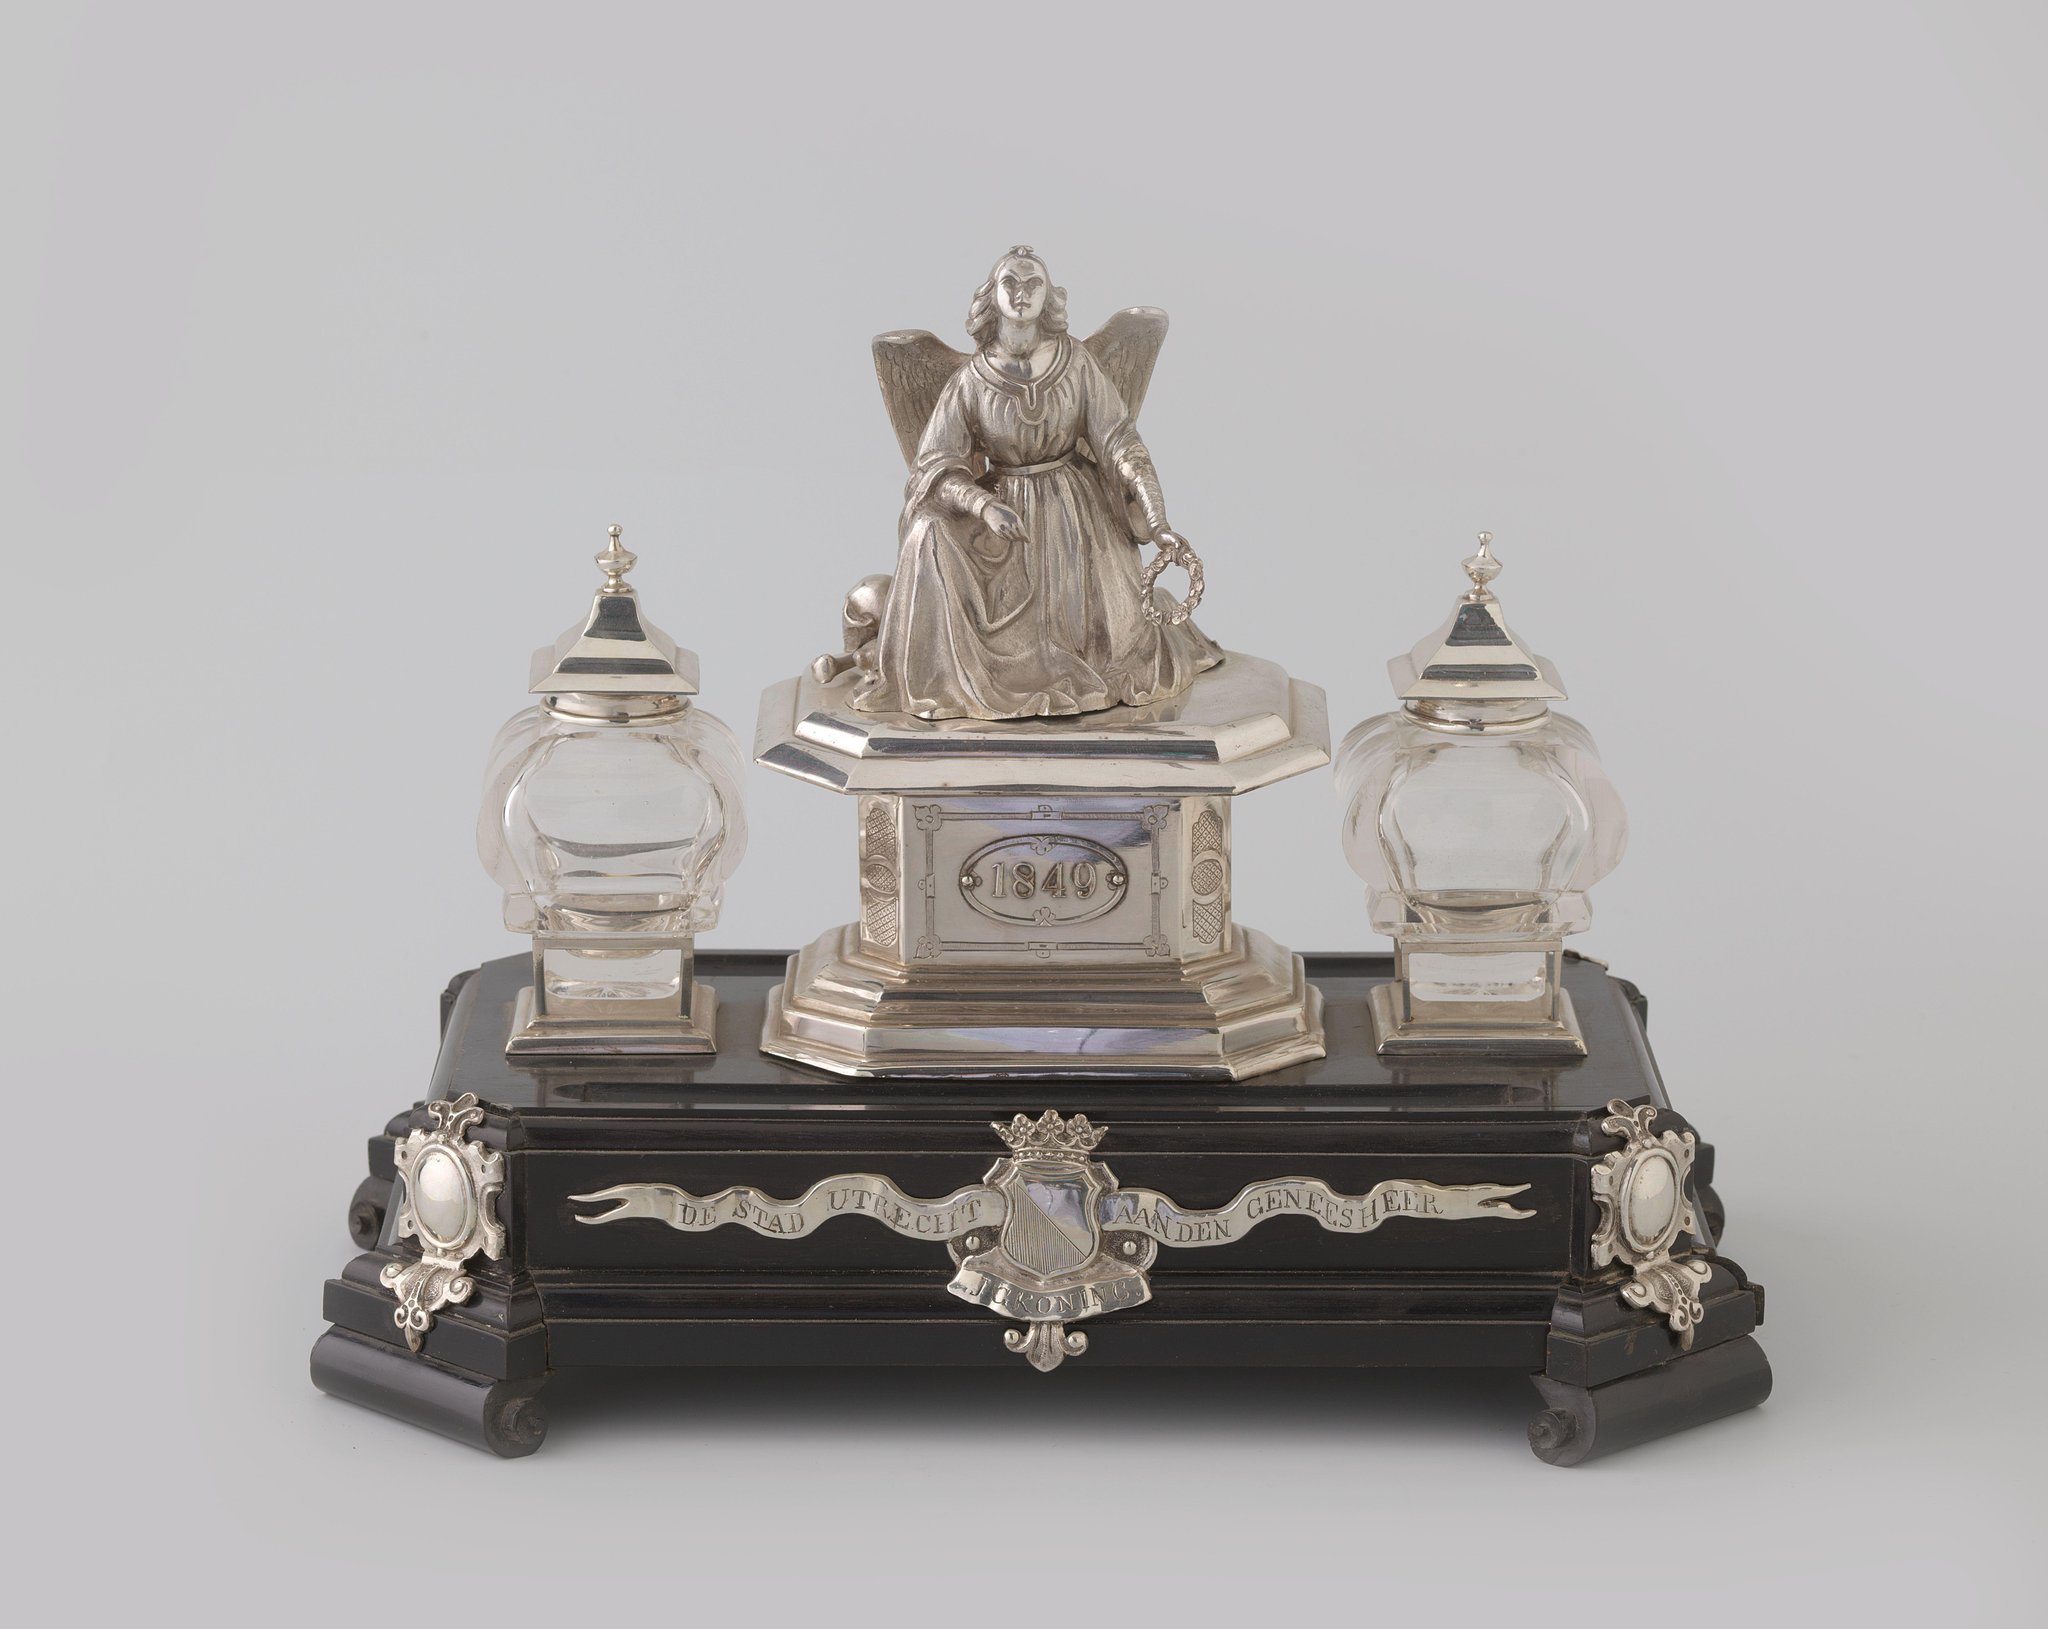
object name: inkstand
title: Inktstel op een houten sokkel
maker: johannes mattheus van kempen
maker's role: silversmith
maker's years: 1814-1877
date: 1850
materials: crystal, iron, silver, wood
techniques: manufacturing, casting, cutting, engraving, forging, striking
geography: utrecht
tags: utrecht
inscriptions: date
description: Inktstel op een zwartgelakte houten sokkel.